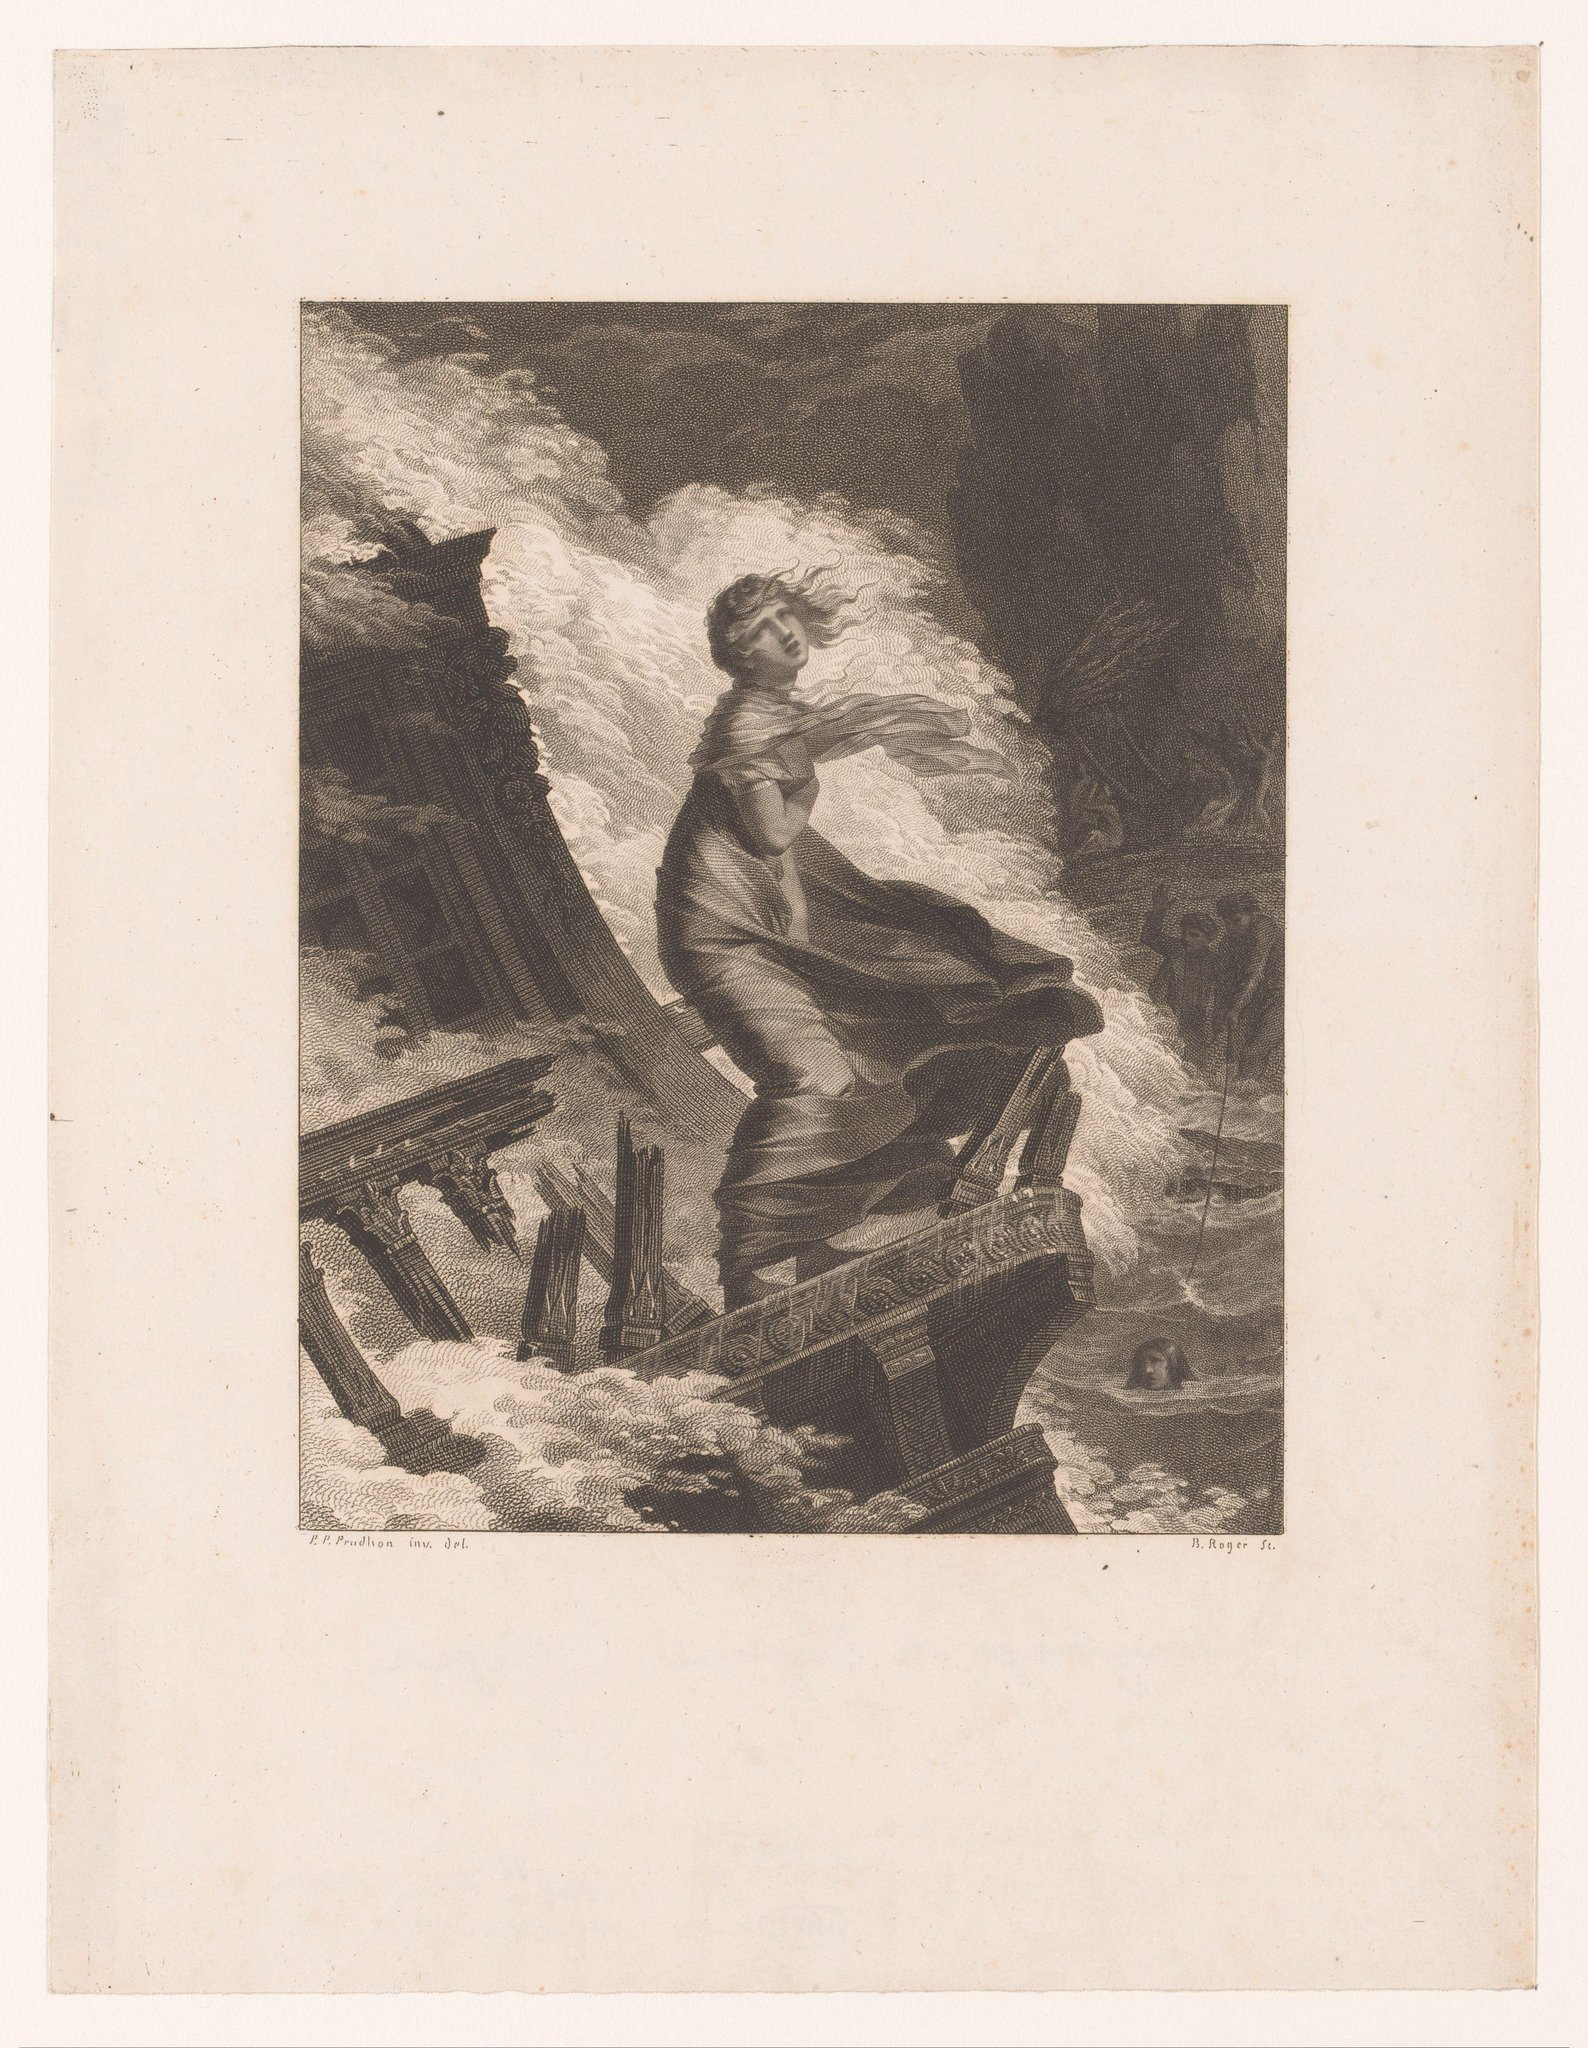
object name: print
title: Schipbreuk van Virginie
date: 1777-1841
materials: paper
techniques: etching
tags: shipping accident; sickness and death at sea, (scenes from) specific works of literature: bernardin de saint-pierre, paul et virginie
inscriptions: collector's mark: Lugt 2228